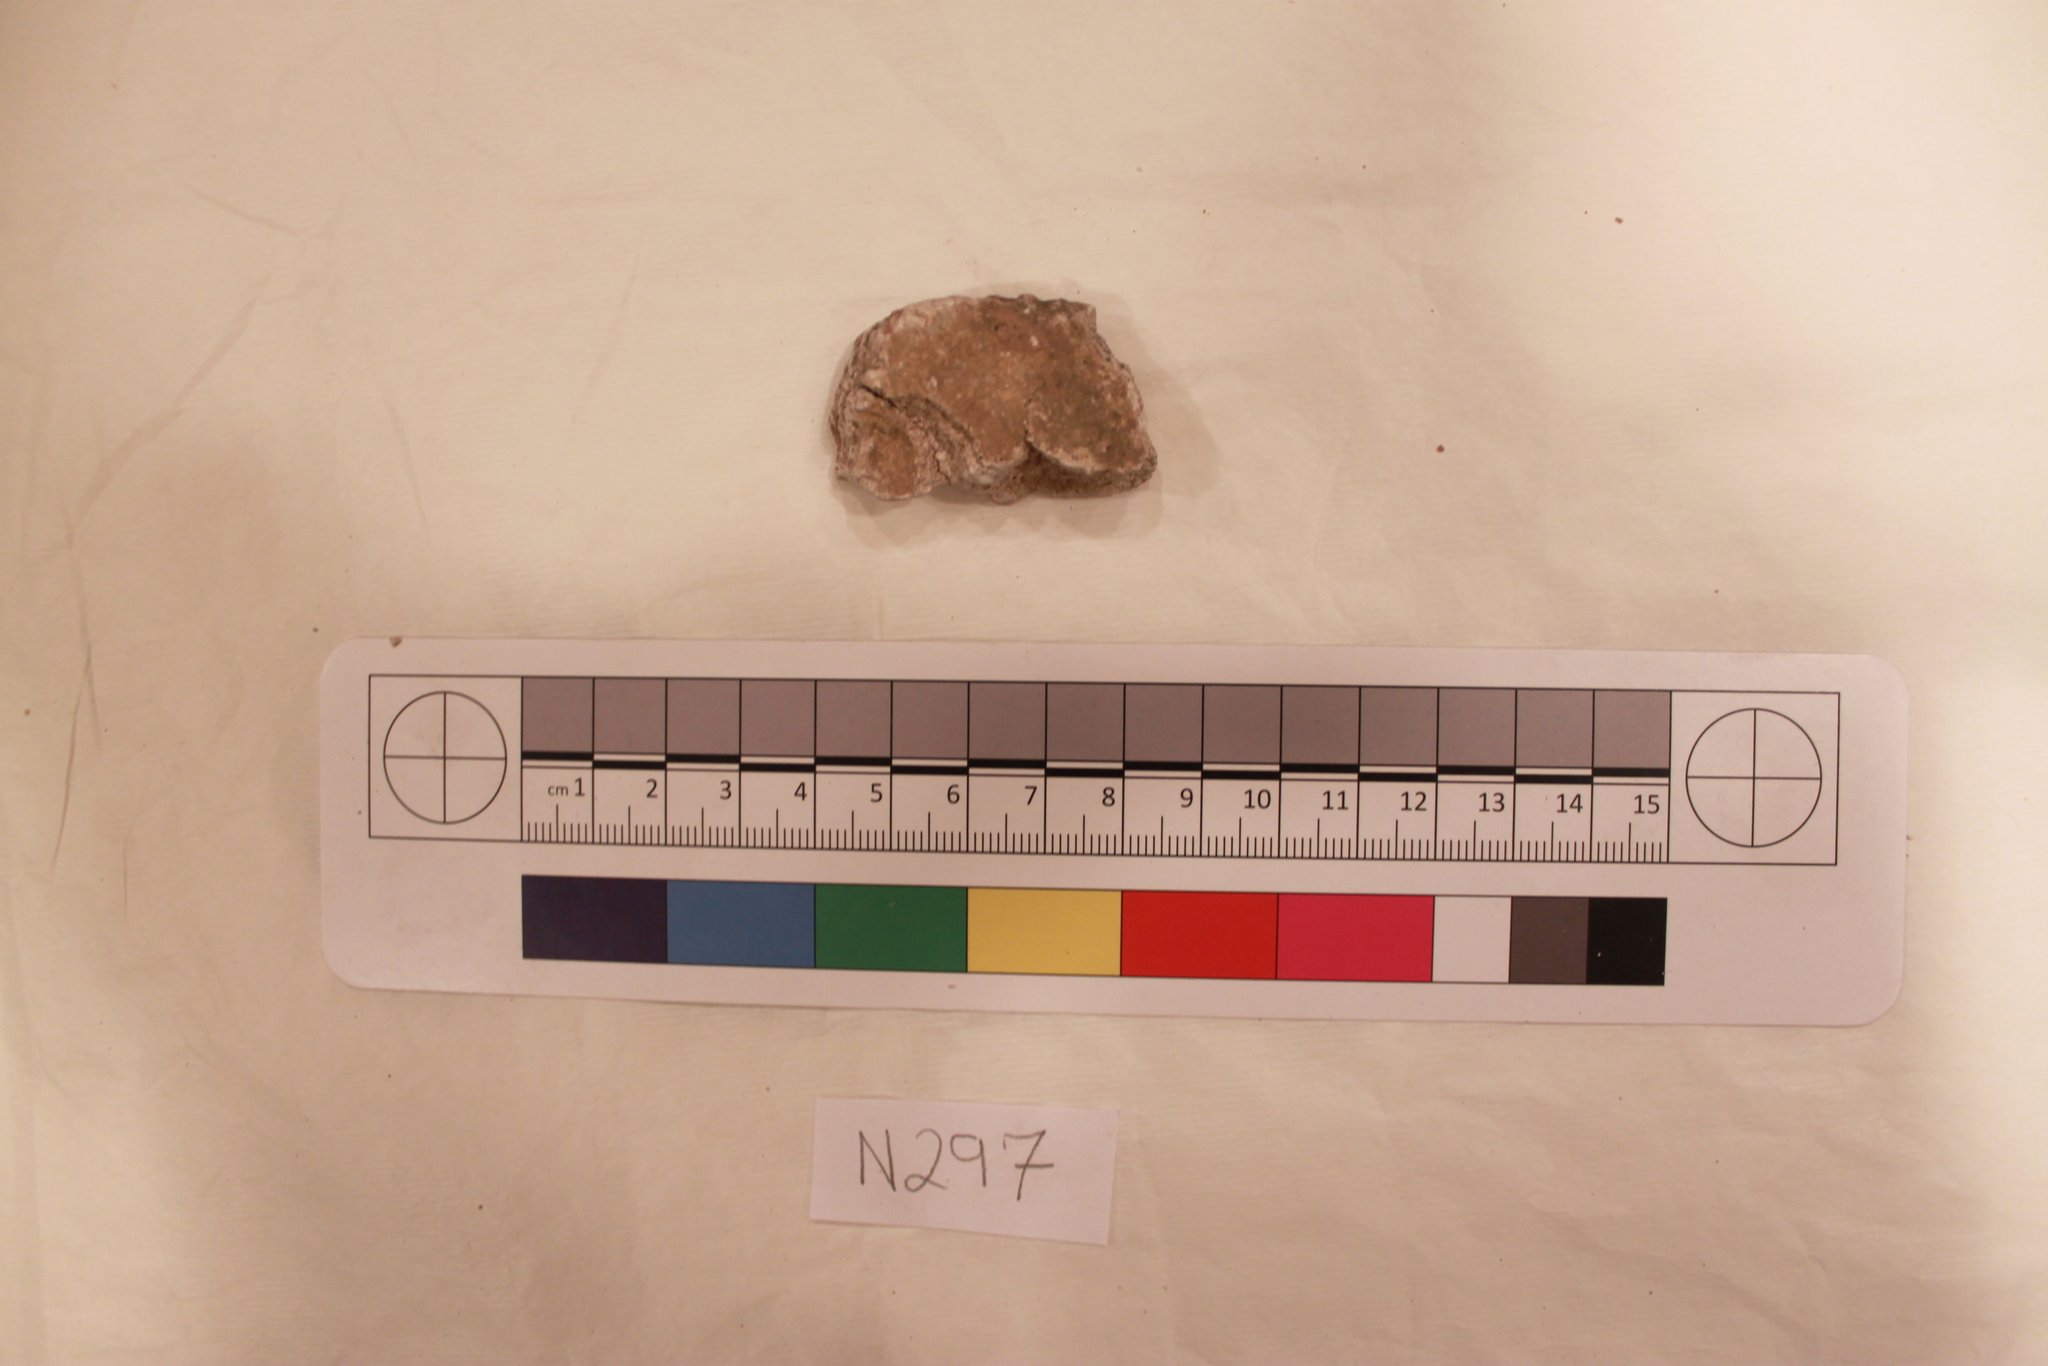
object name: fragment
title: Stucco Fragment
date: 701-1200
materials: plaster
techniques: carving, painting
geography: iran